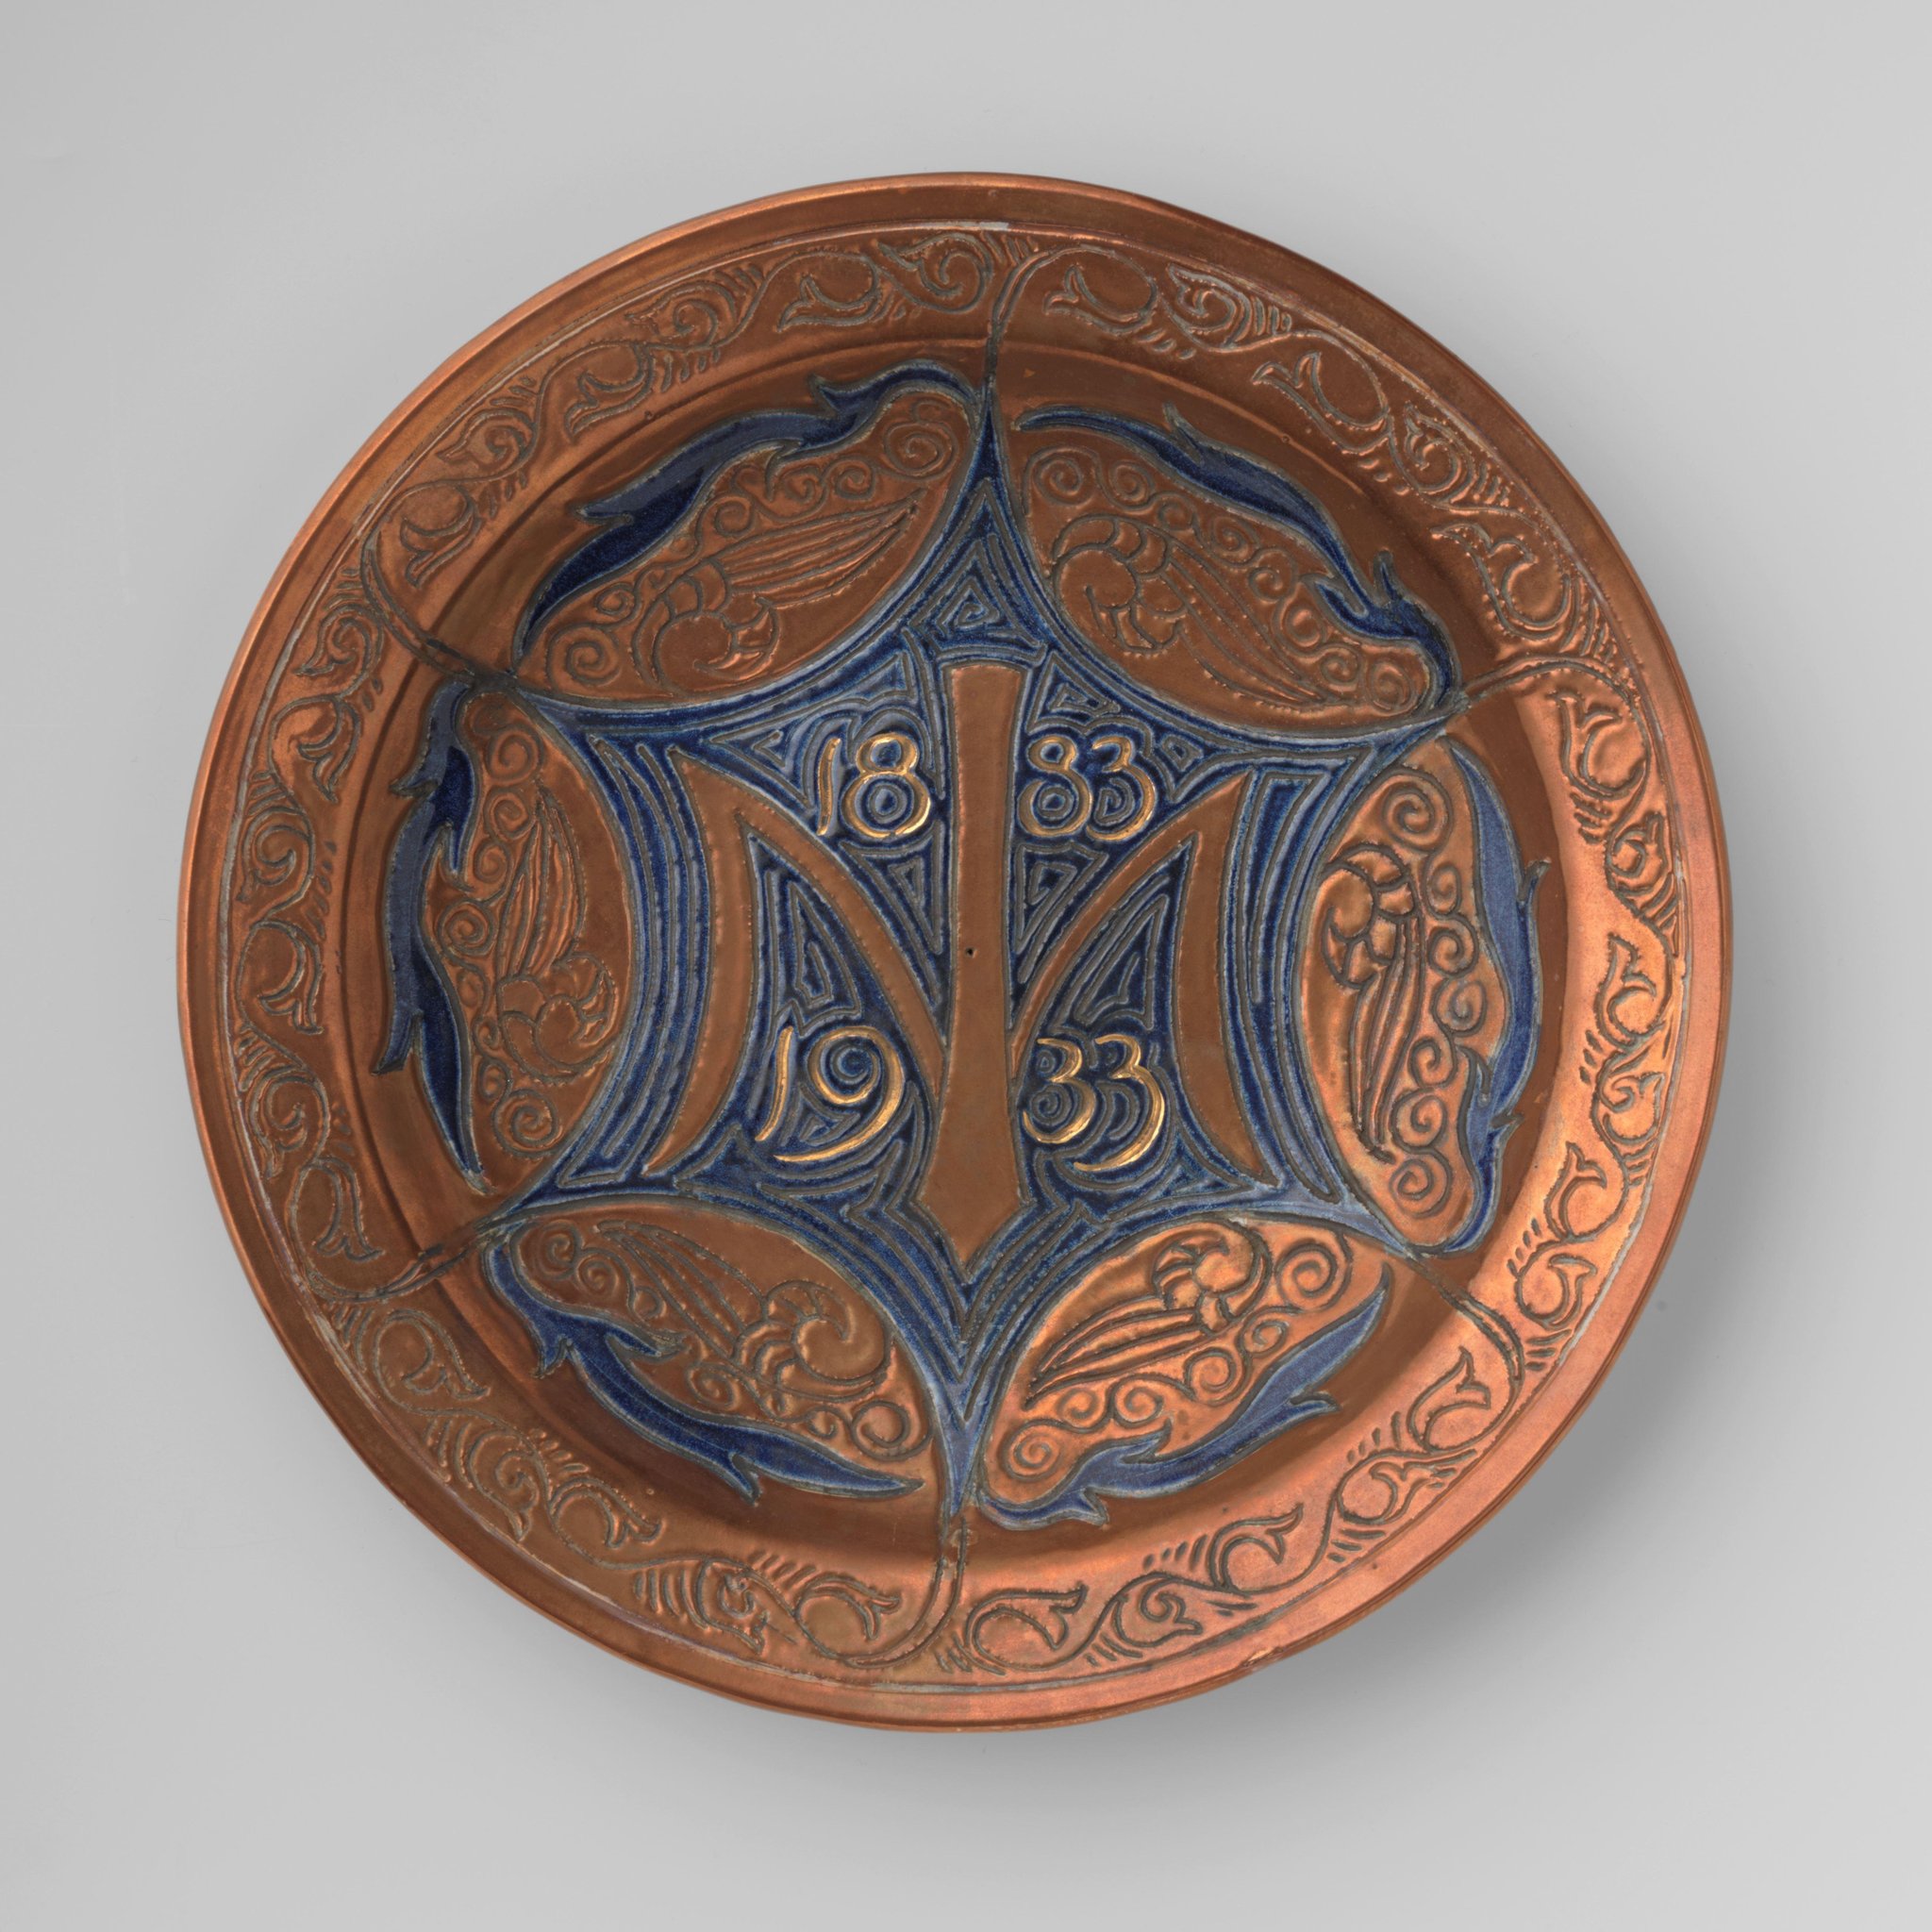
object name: plate dish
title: Wandbord ter gelegenheid van het 50-jarig huwelijksfeest J.R. Tutein Nolthenius en M.A. Cordes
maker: carel adolph lion cachet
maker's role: draughtsman, print maker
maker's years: 1864-1945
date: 1933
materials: earthenware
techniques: vitrification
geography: gouda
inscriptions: mark: ‘GOEDEWAAGEN-GOUDA’, mark: ‘JULIE JACQUES/ LC 1933’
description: Wandbord ter gelegenheid van het 50-jarig huwelijksfeest J.R. Tutein Nolthenius en M.A. Cordes: 1883-1933. Lichtgele scherf, waarover een blauwig witte engobe, waarin het decor is ingekrast, daarna geglazuurd, deels in blauw, deels in goudluster. Op het plat staat binnen een zespuntige ster het monogram JM en de jaartallen 1883 en 1933. Buiten de ster blad- en vleugelmotieven en ranken, die ook de rand versieren. Op de achterkant van het bord ingesneden in de ongeglazuurde scherf: van JULIE en JACQUES (binnen een cirkel), daaronder LC en 1933. Ophanggaten in de voetring.